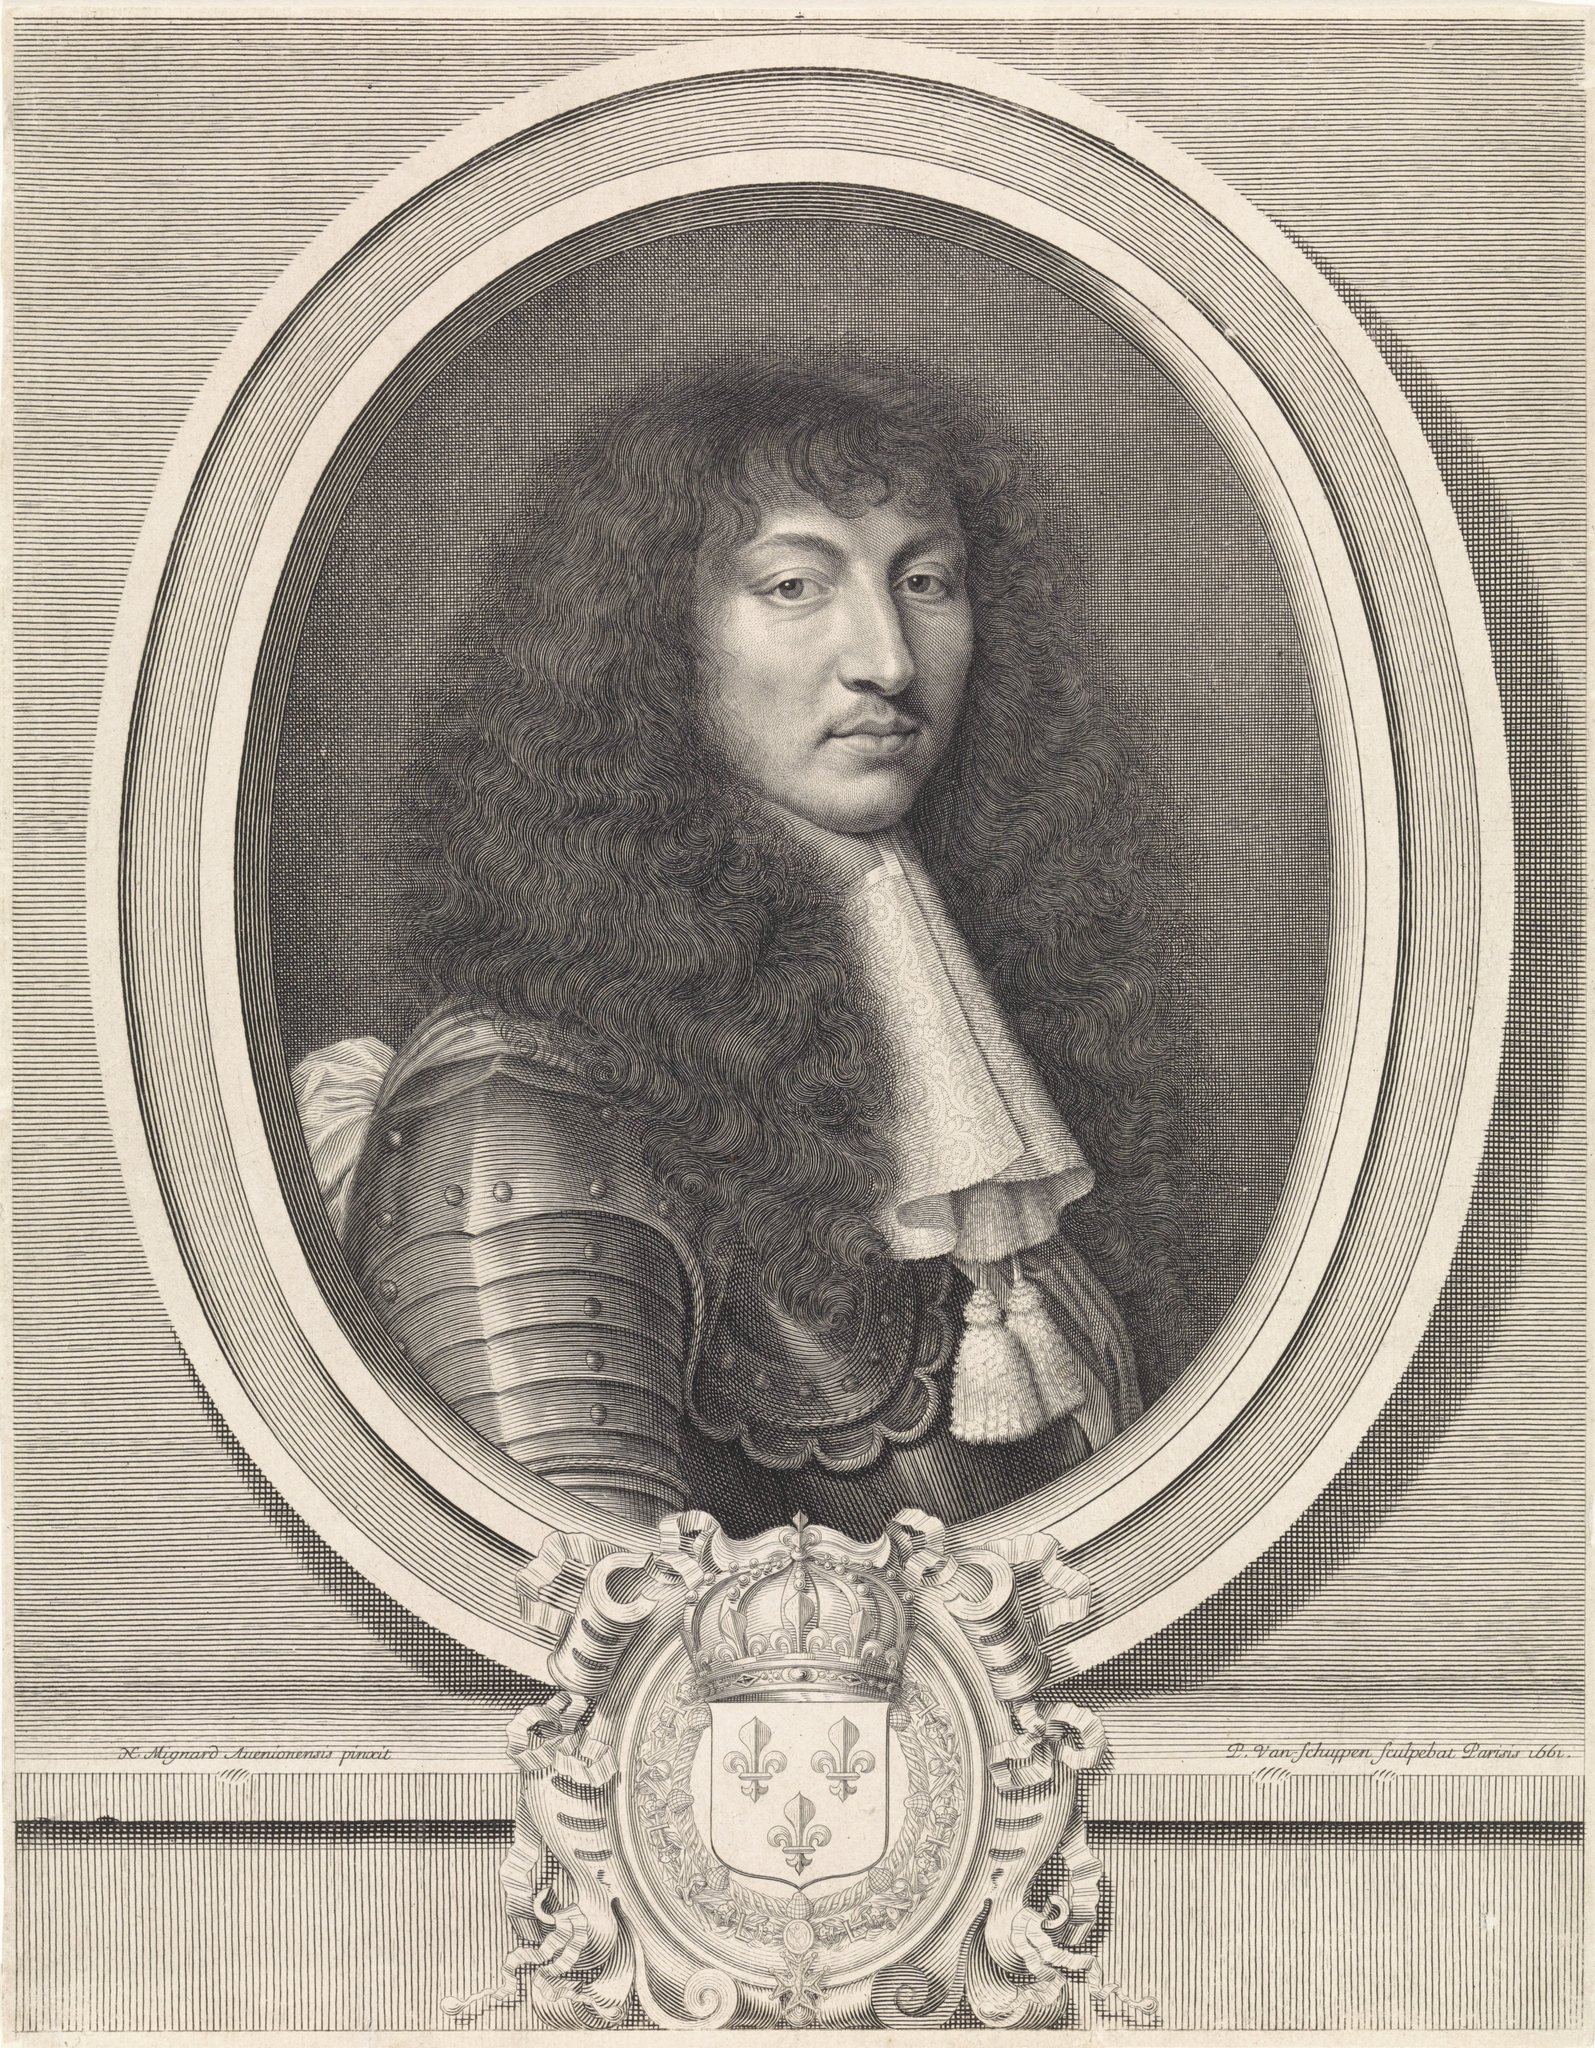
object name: print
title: Portret van Lodewijk XIV, koning van Frankrijk, met kanten kraag voorzien van twee kwasten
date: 1661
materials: paper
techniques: engraving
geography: paris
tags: lodewijk xiv (koning van frankrijk)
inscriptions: collector's mark: Lugt 2228